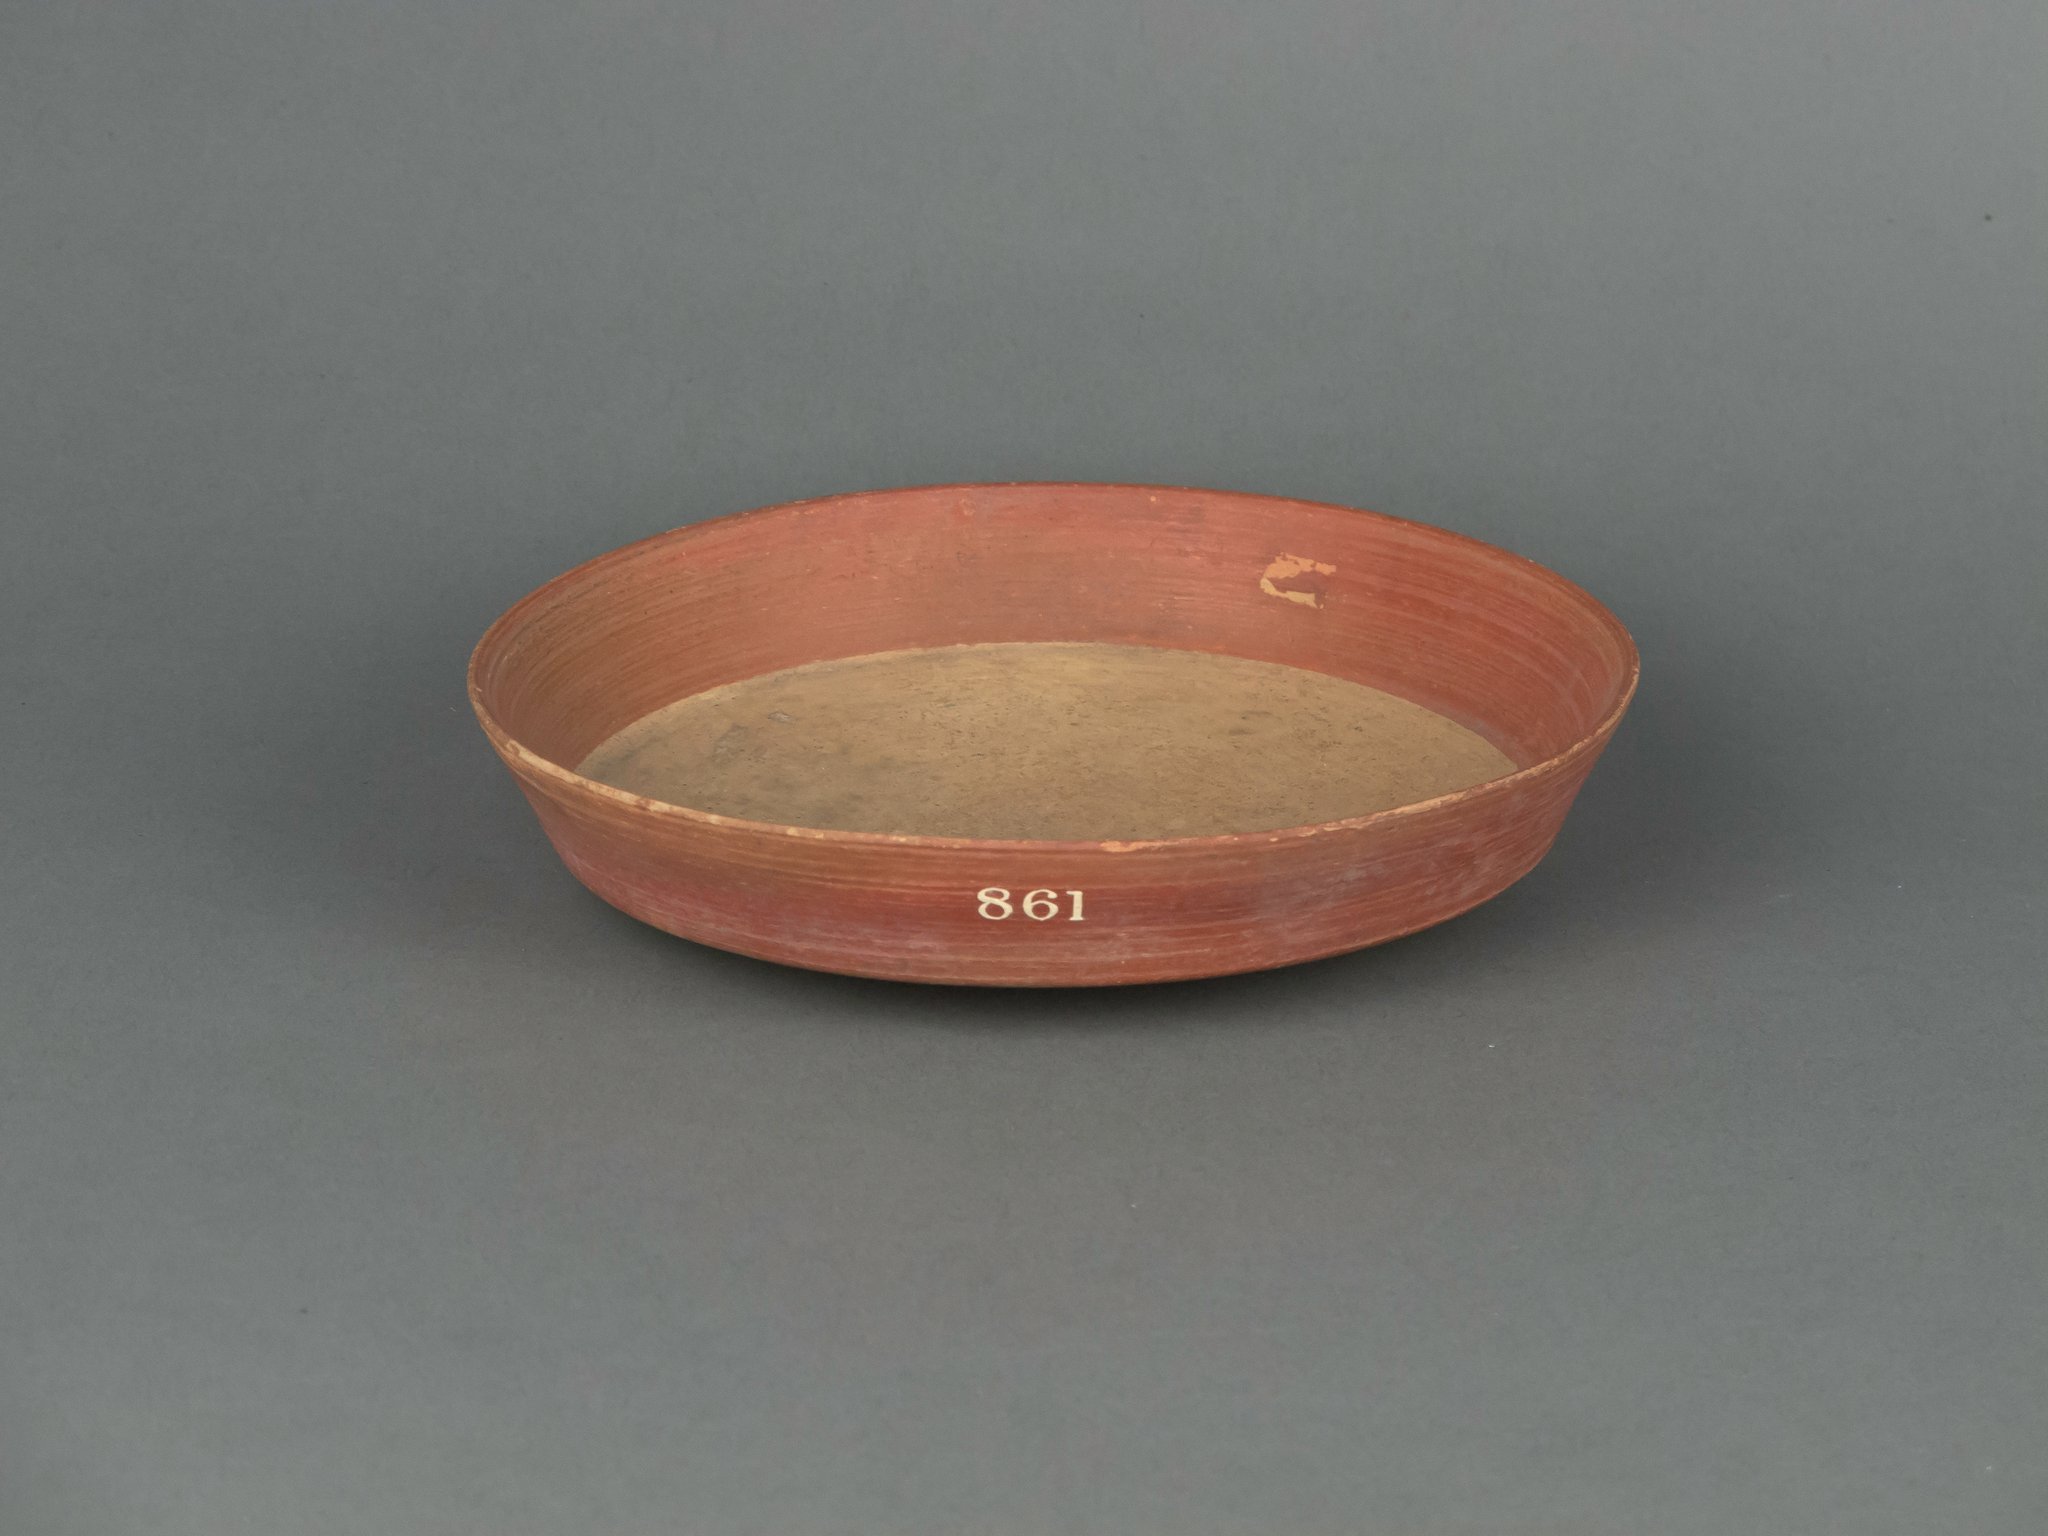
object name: bowl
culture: cypriot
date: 750-600 BCE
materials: terracotta